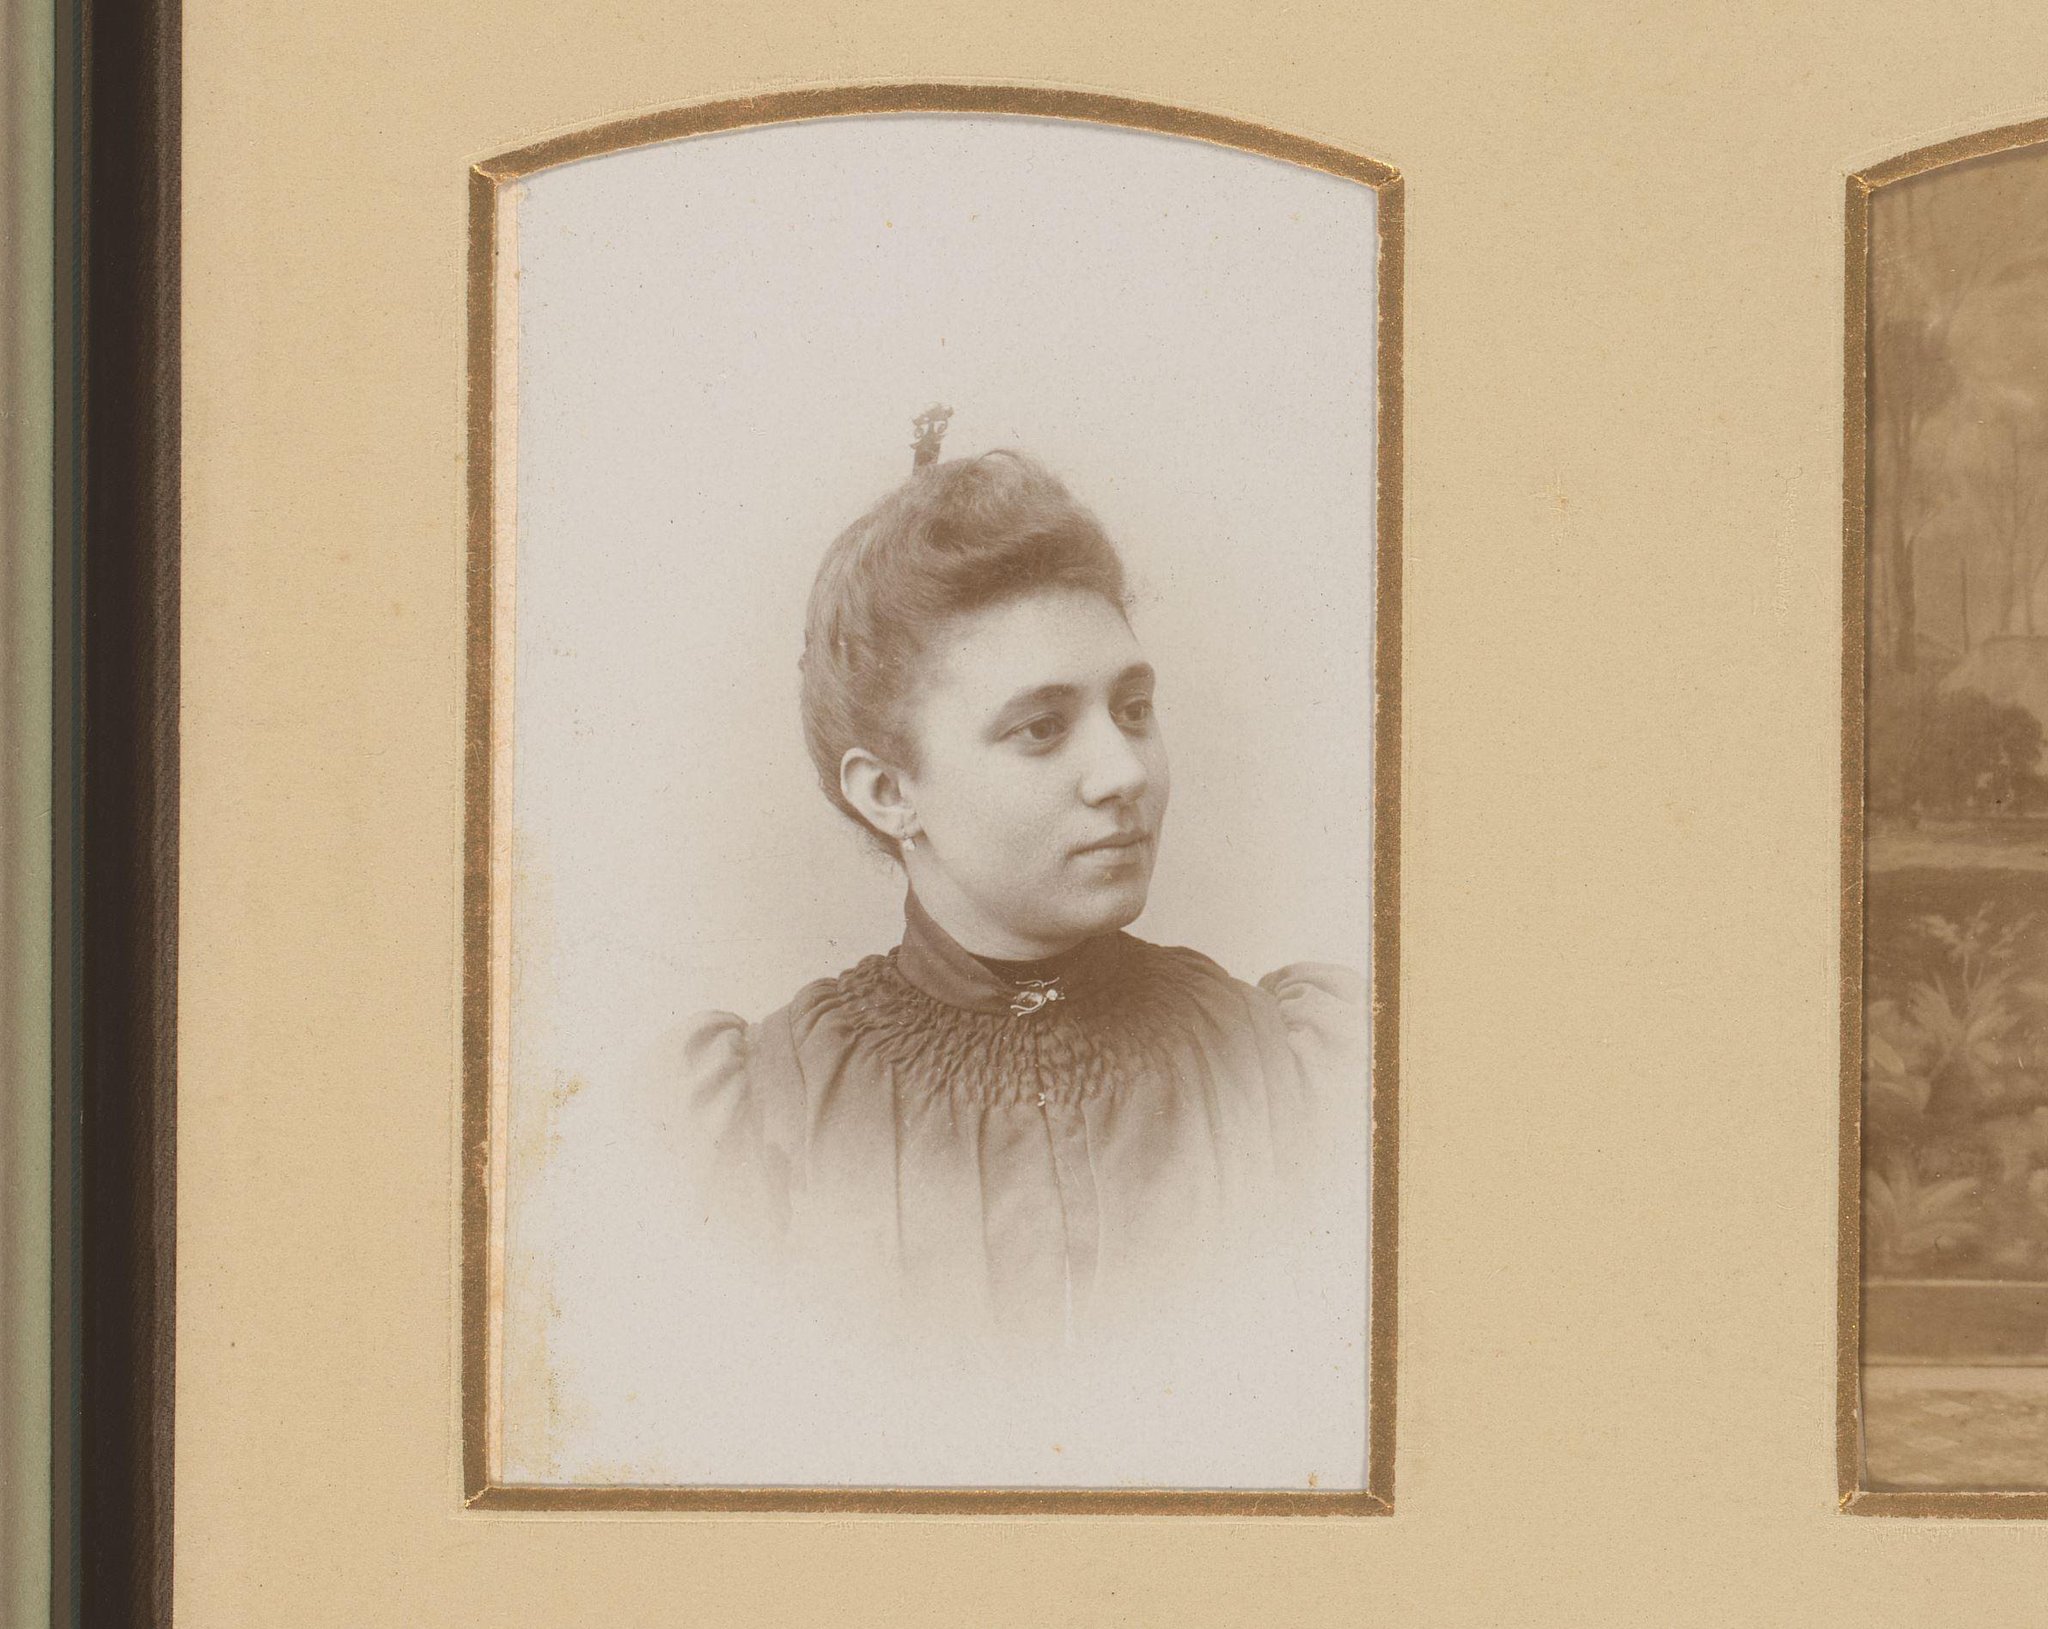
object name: photograph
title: Portret van een jonge vrouw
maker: cornelis johannes lodewicus vermeulen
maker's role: fotograaf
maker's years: 1861-1936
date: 1888-1896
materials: cardboard, photographic support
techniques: collodion silver print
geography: amsterdam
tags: adolescent, young woman, maiden, historical persons - bb - woman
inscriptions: inscription: ‘Photographische/ Ateliers/ C.J.L. Vermeulen/ Heerenstraat 6,/ Heiligenweg/ hoek Singel/ Amsterdam./ Specialiteit in vergrootingen.’